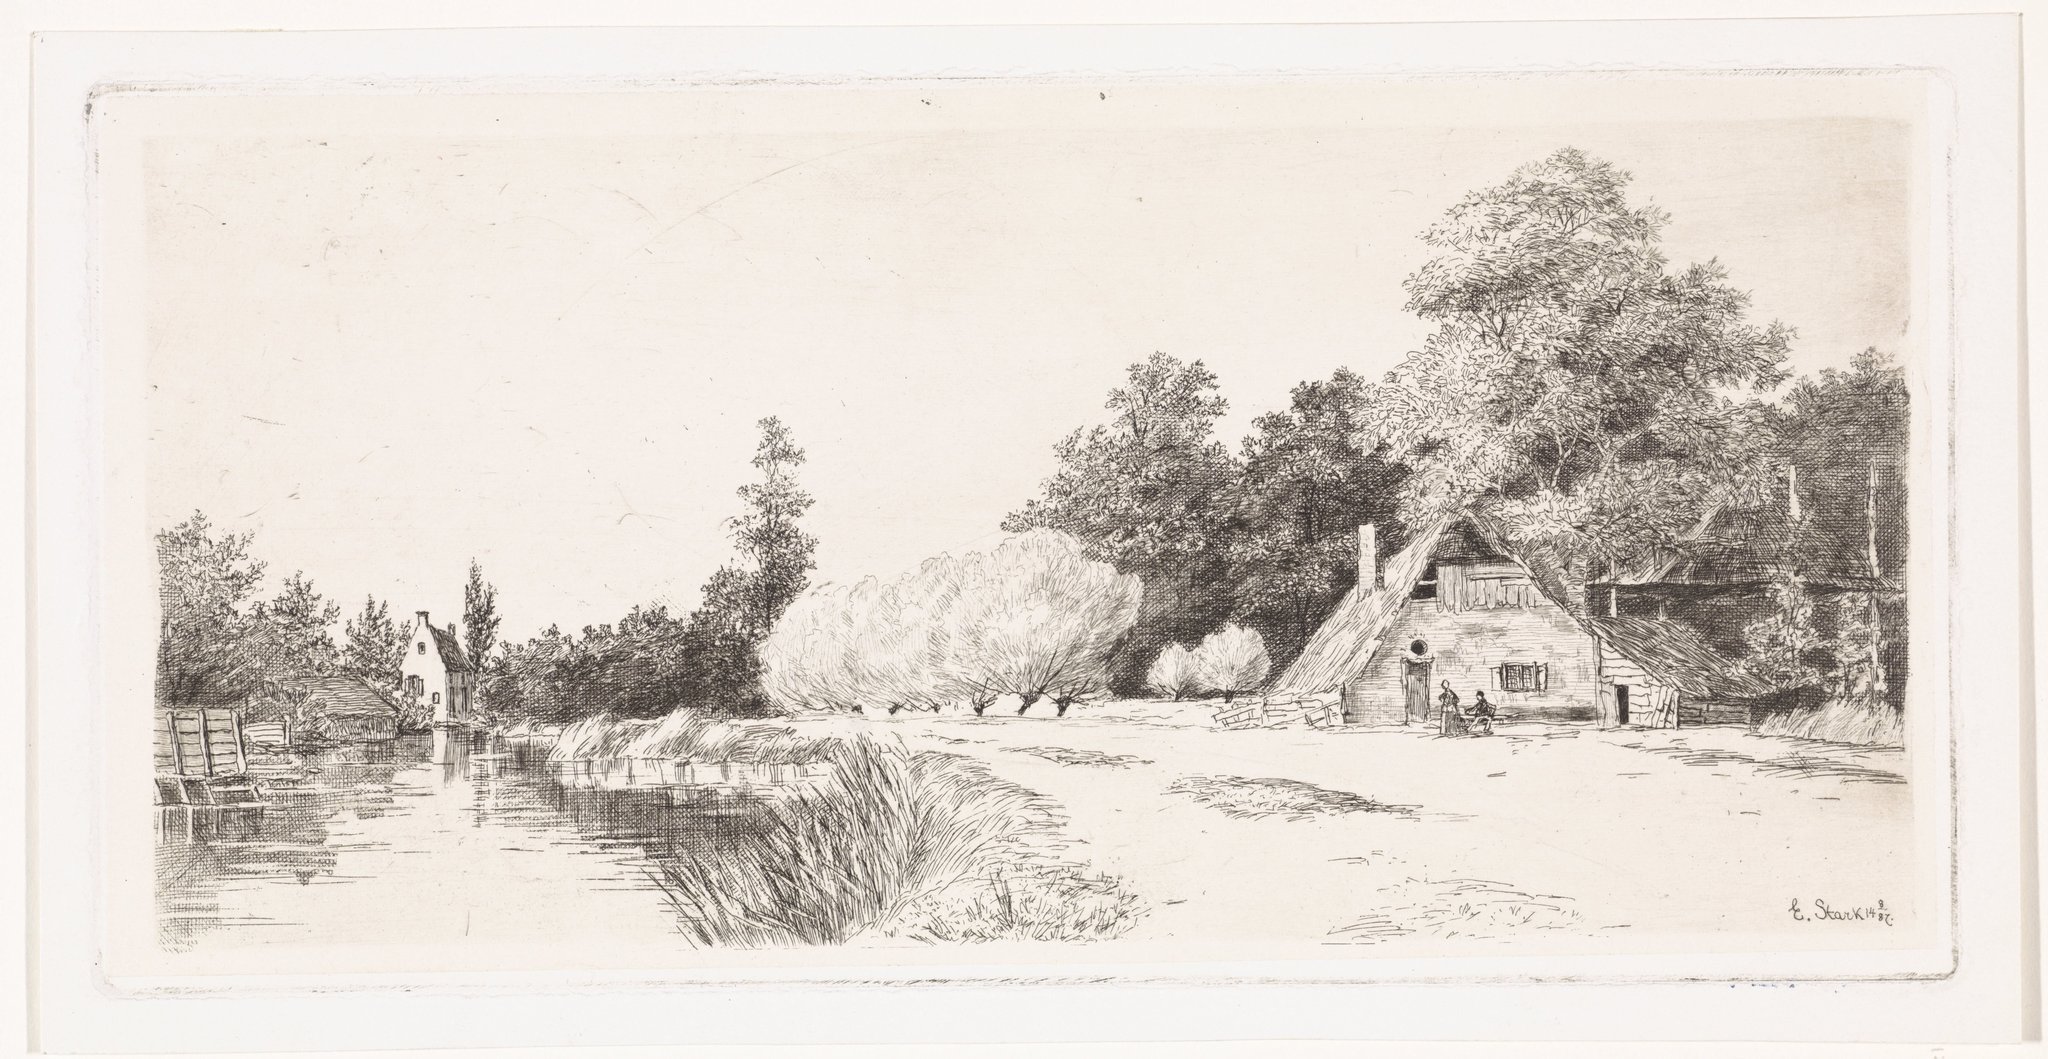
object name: print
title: Landschap bij Baambrugge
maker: elias stark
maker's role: draughtsman, print maker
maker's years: 1849-1933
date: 1887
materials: paper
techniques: drypoint, etching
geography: nieuwer-amstel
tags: river, farm or solitary house in landscape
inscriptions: collector's mark: Lugt 2228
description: Huizen langs het riviertje de Angstel in Baambrugge. Achter de boerderij een hooiberg.